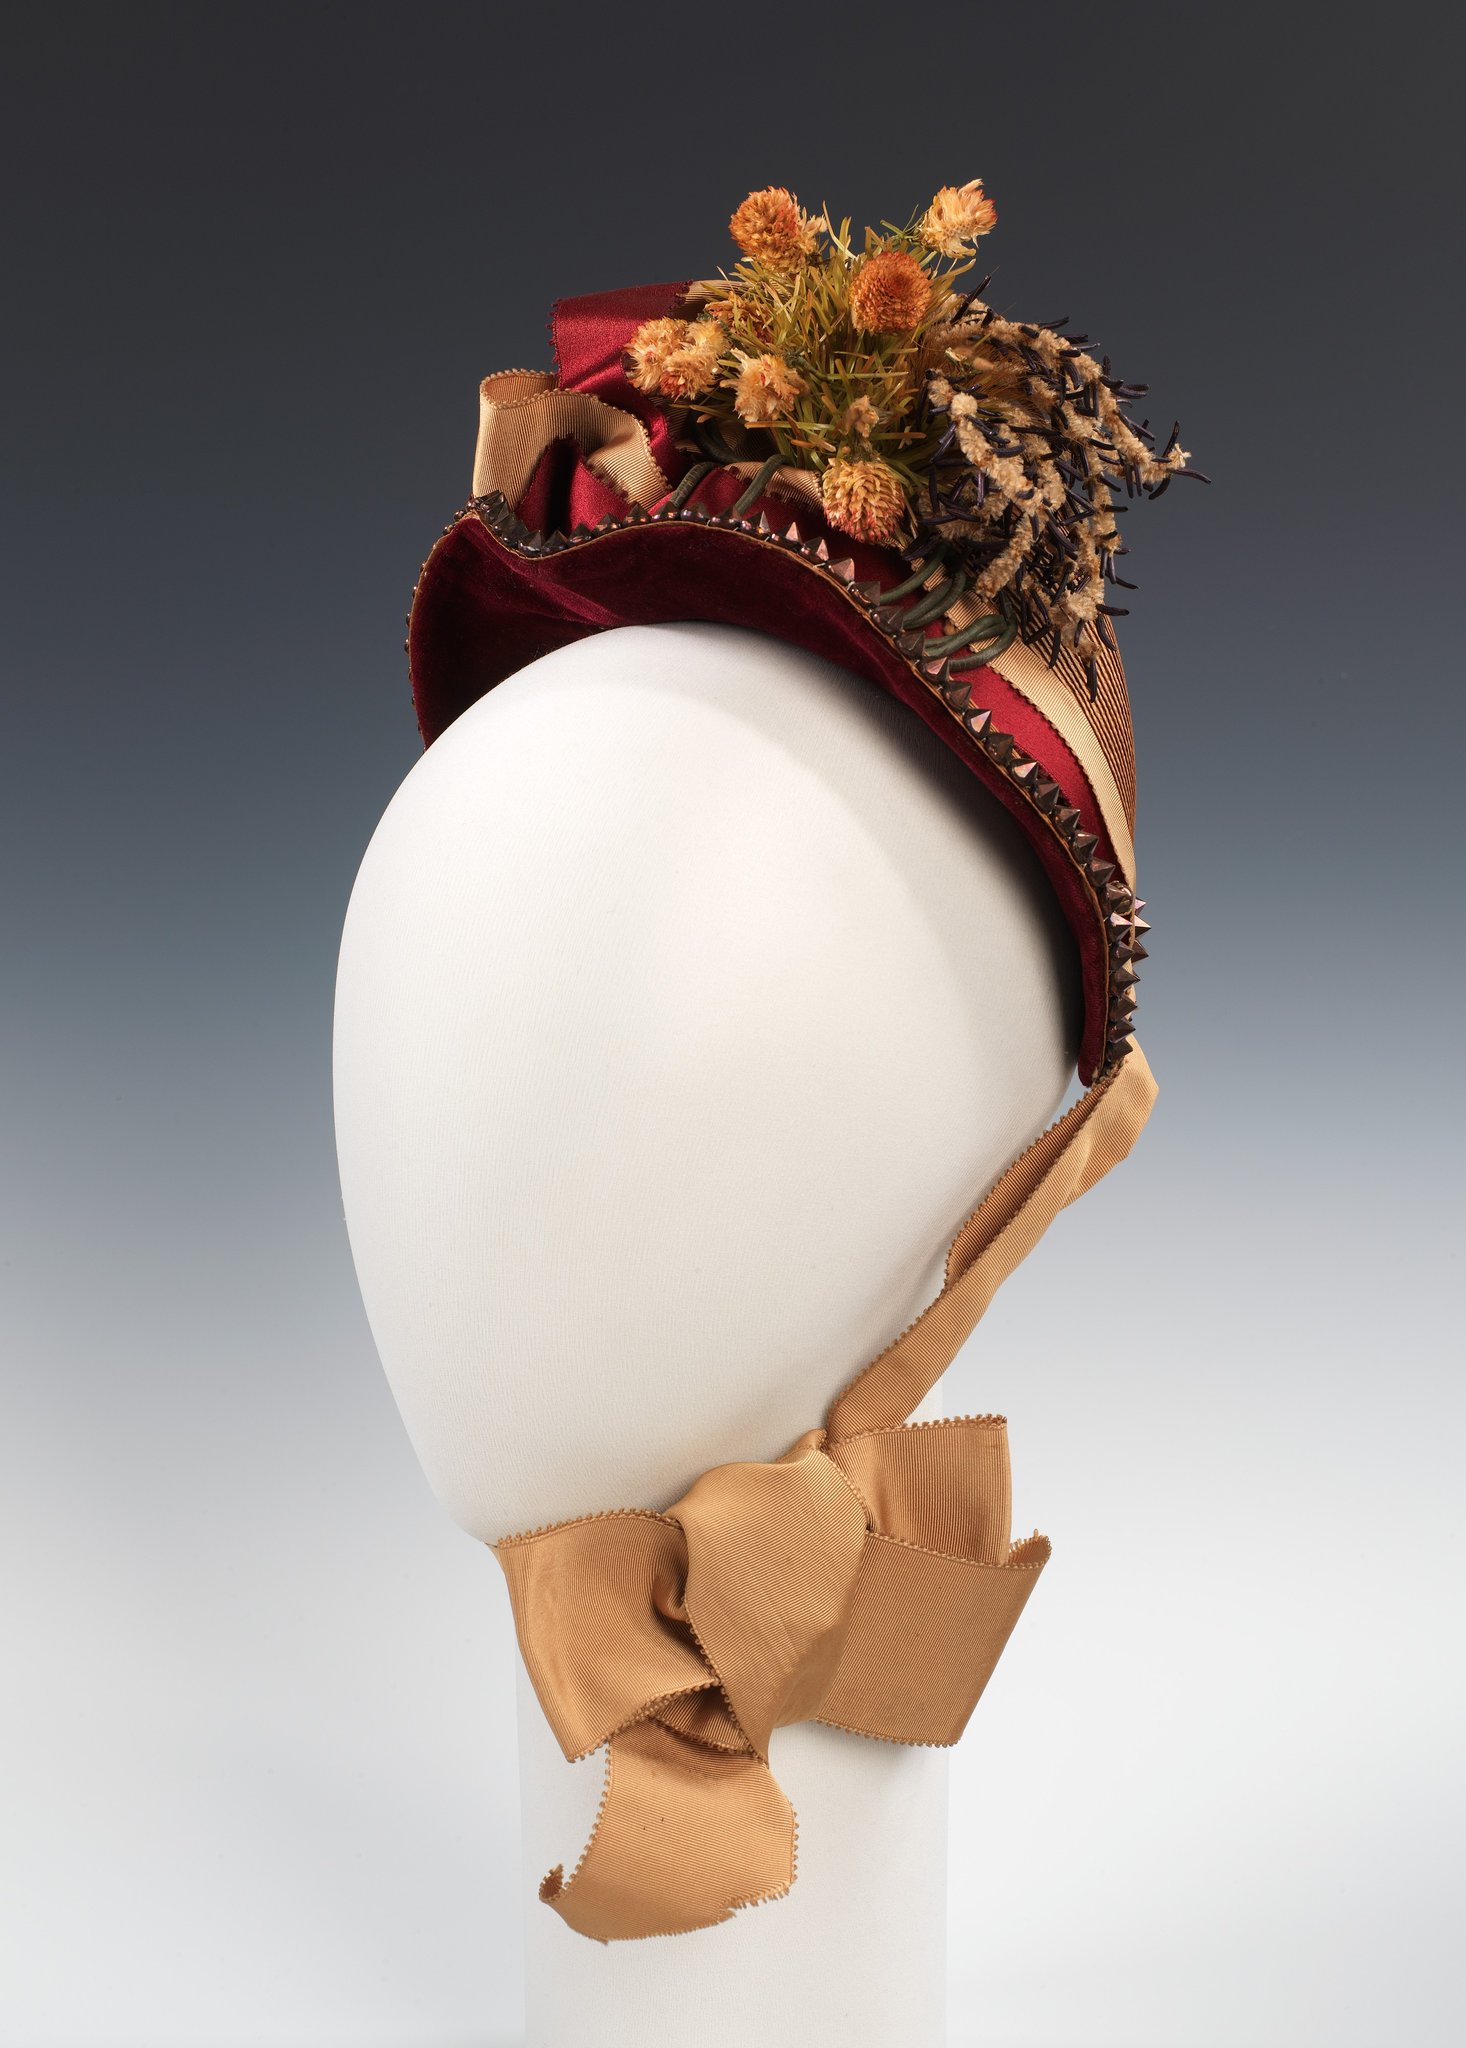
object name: bonnet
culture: american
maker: h. o. hanlon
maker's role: designer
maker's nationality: american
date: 1887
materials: cotton, metal, silk, fiber